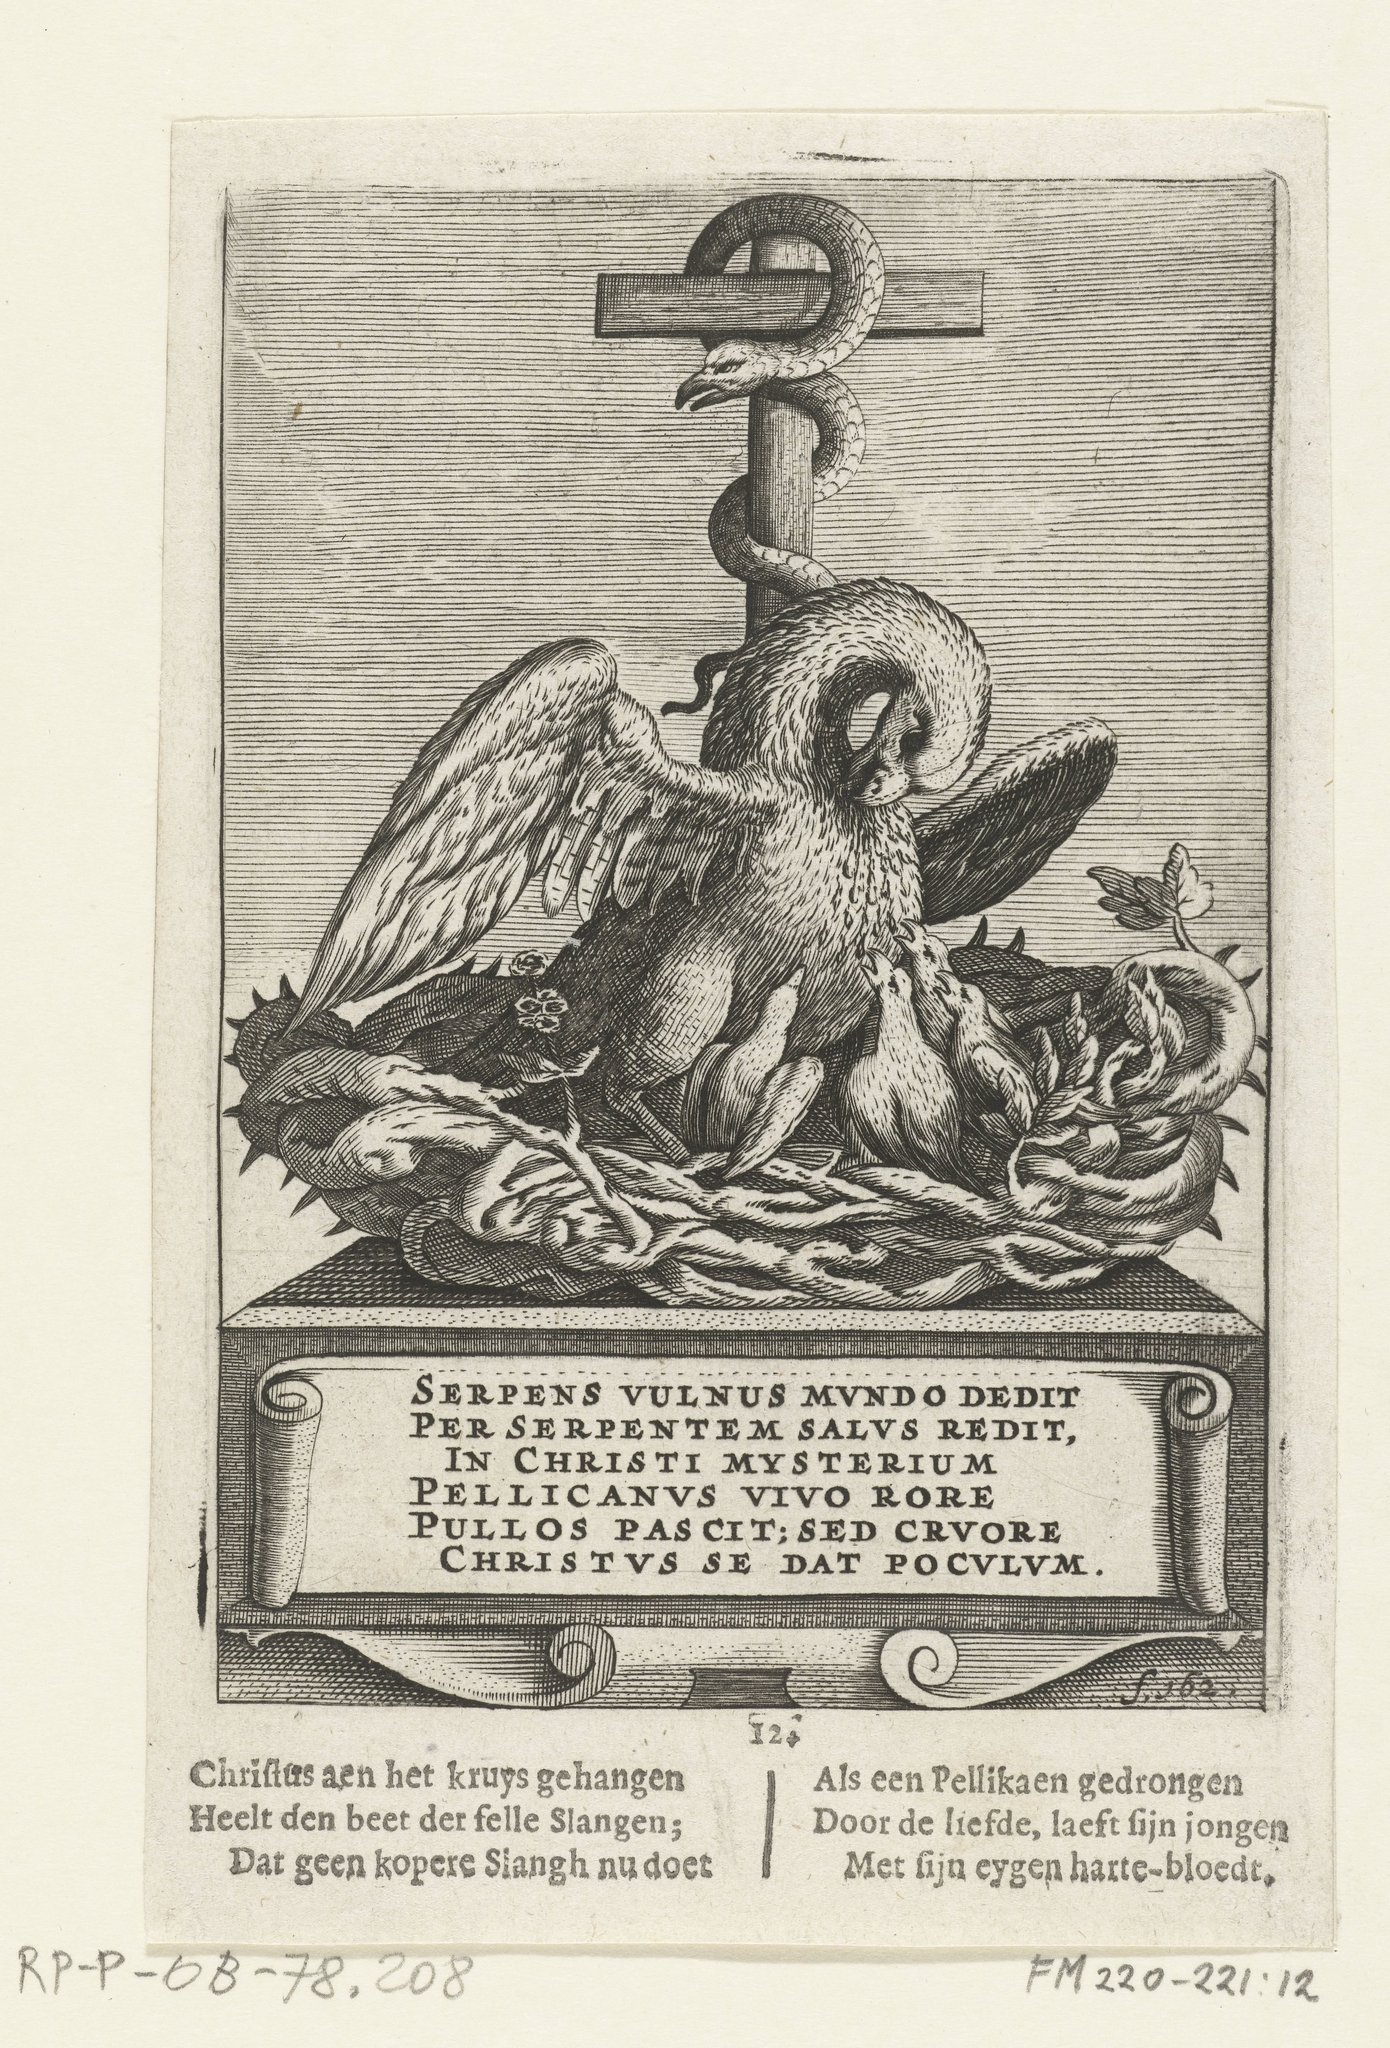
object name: print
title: Het Mirakel van Amsterdam (kopie), 1345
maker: Anonymous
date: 1639-1699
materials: paper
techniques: engraving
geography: low countries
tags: symbols of christ ~ animals, amsterdam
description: Allegorische embleem met de pelikaan die zich in de borst pikt om haar jongen met haar eigen bloed te voeden samen met de koperen slang om het kruis. Prent nr. 12 uit de serie van 16 voorstellingen van Het Mirakel van Amsterdam, naar de gebeurtenissen op 15 maart 1345. Kopieën naar de reeks van Bolswert. Onder de voorstelling in de plaat gegraveerd een zesregelig vers in het Latijn, daaronder een zesregelig vers in boekdruk in het Nederlands.